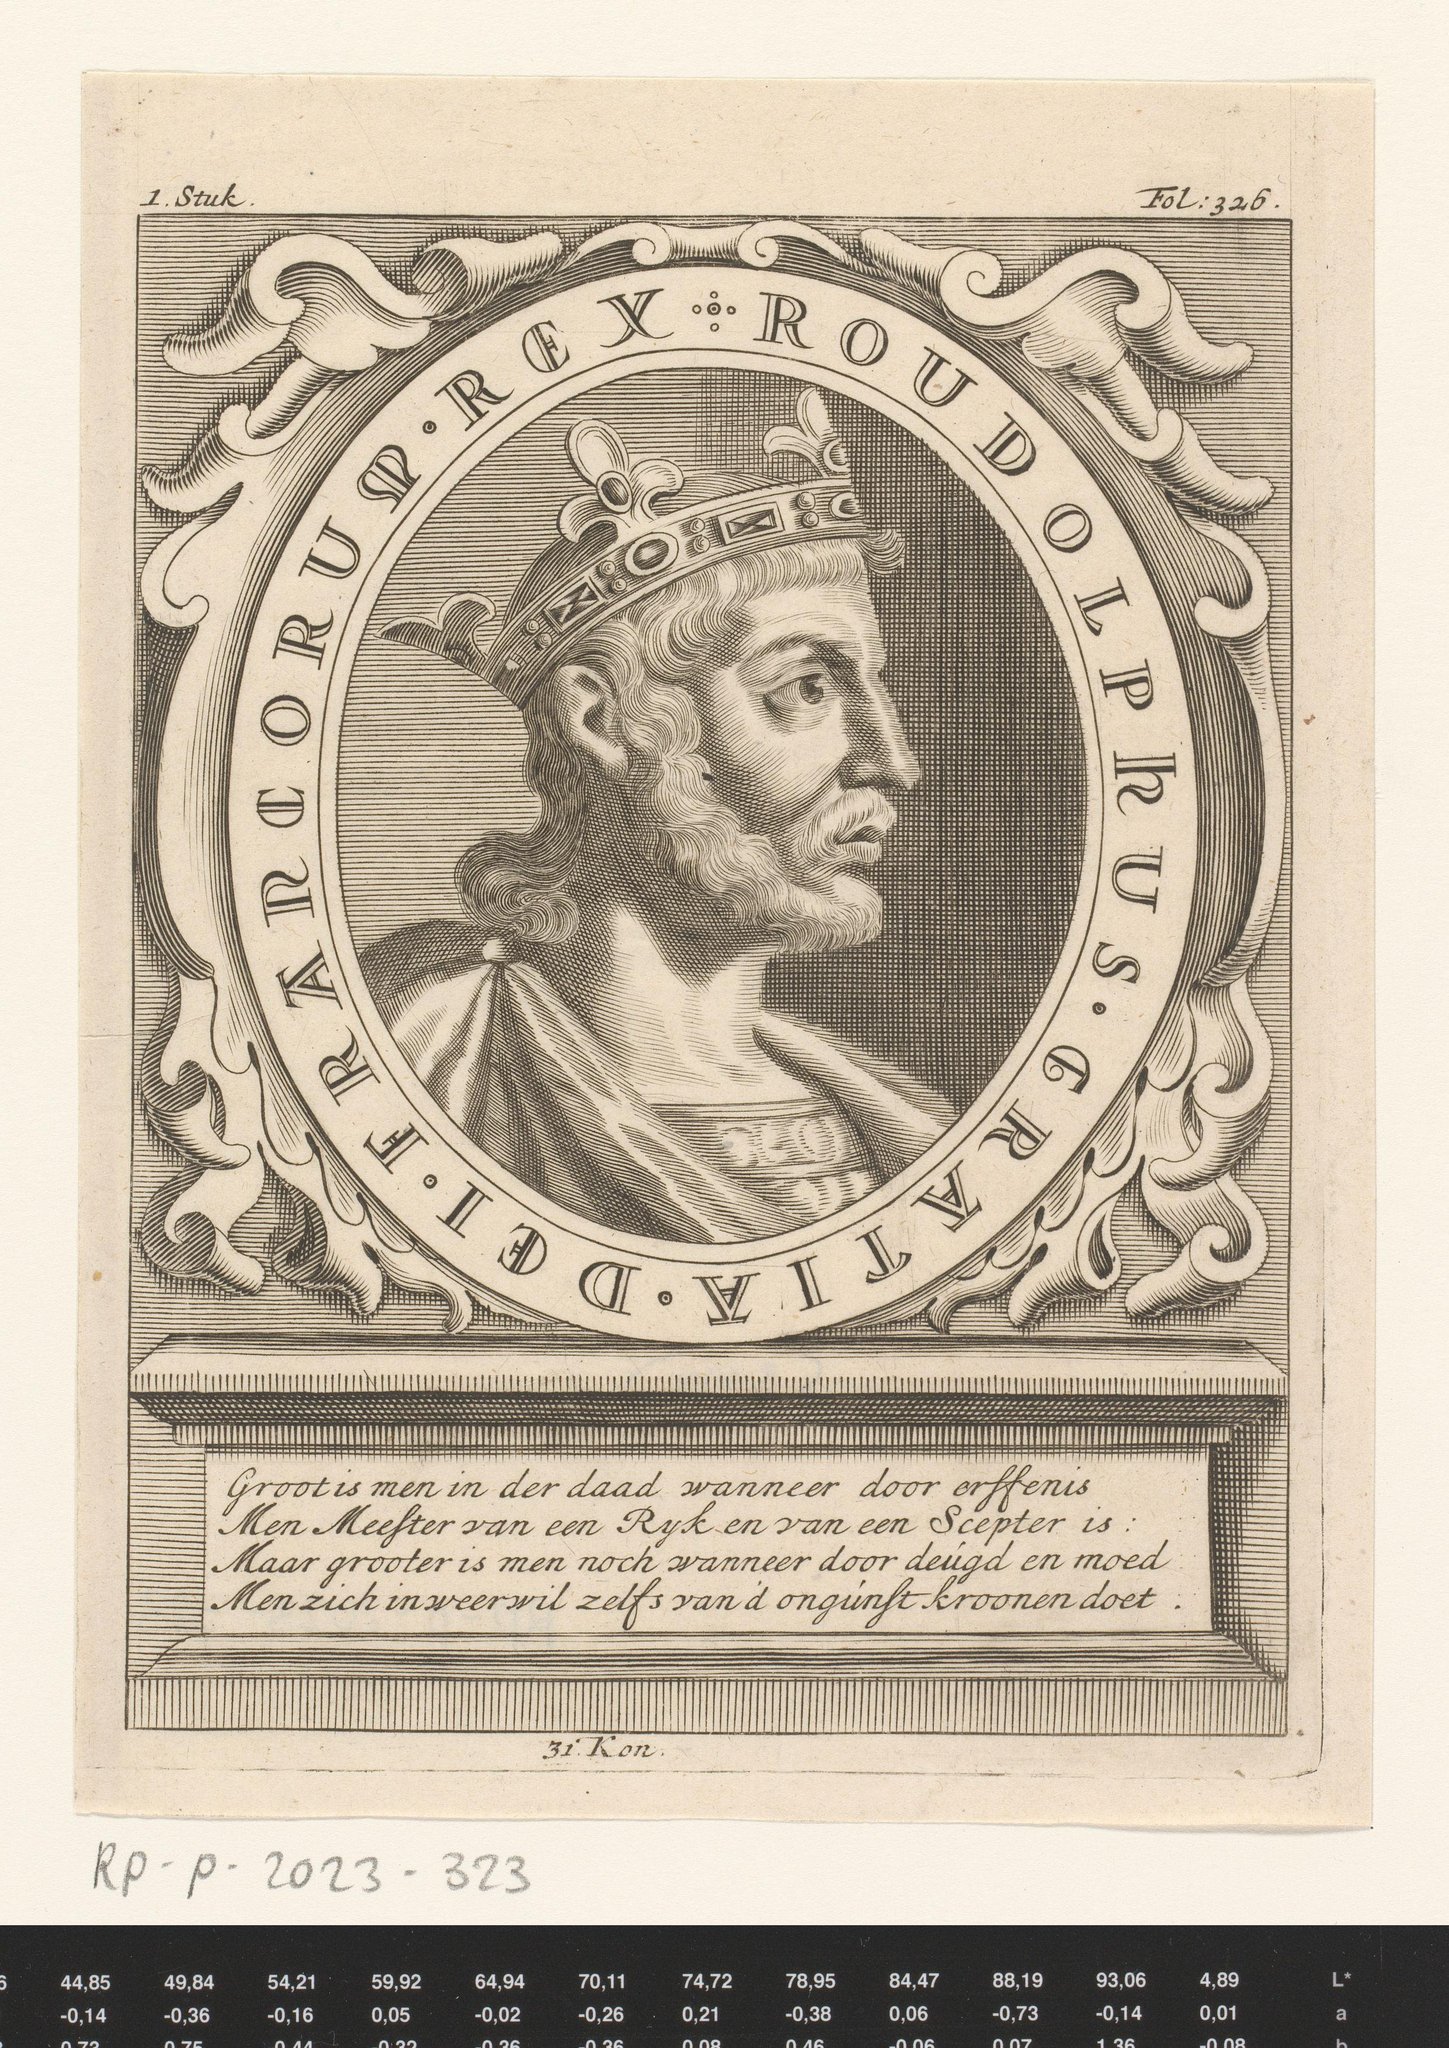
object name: print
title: Portret van Rudolf van Frankrijk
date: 1685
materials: paper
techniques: engraving, etching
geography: amsterdam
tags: historical persons, king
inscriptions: collector's mark: Lugt 2228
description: Prent uit: Mézeray, François Eudes de. Chronyk van Vrankryk. [Vertaald uit het Frans door] G. v. Broekhuizen. Amsterdam: Timotheus ten Hoorn en Jan Bouman, 1685, dl. 1, p. 326.